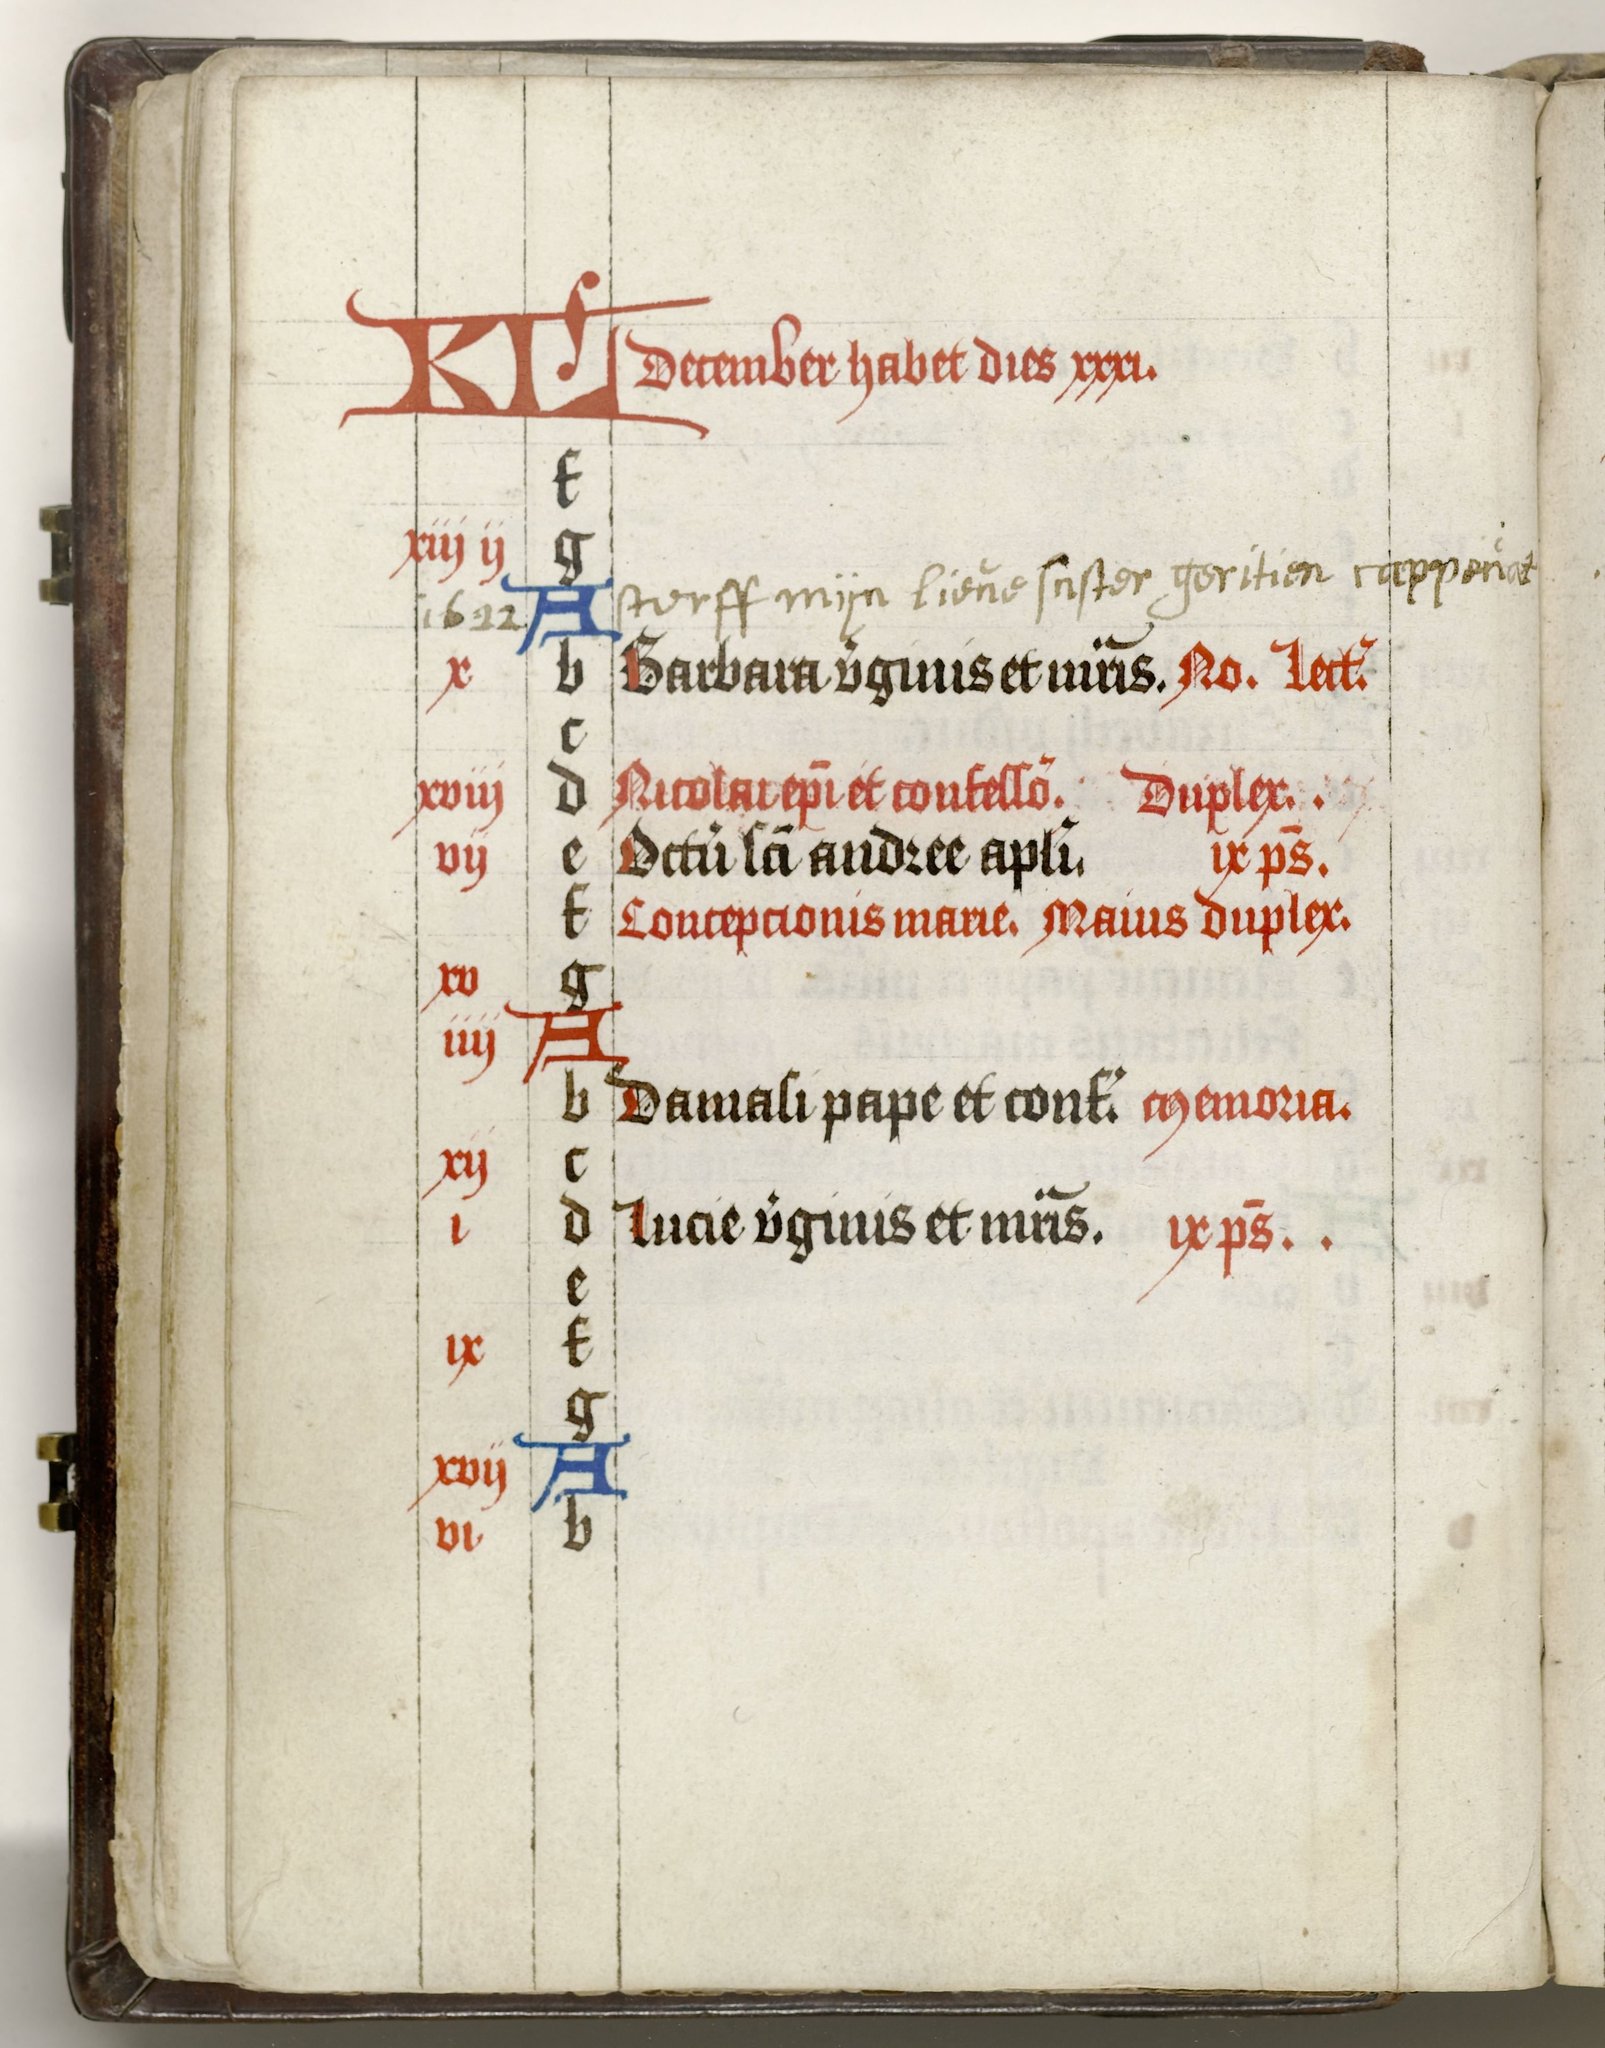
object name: manuscript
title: Psalter en brevier (gedeeltes) in het Latijn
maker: Anonymous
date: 1500-1600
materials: paint, paper, parchment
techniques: pen in colors, brush in colors